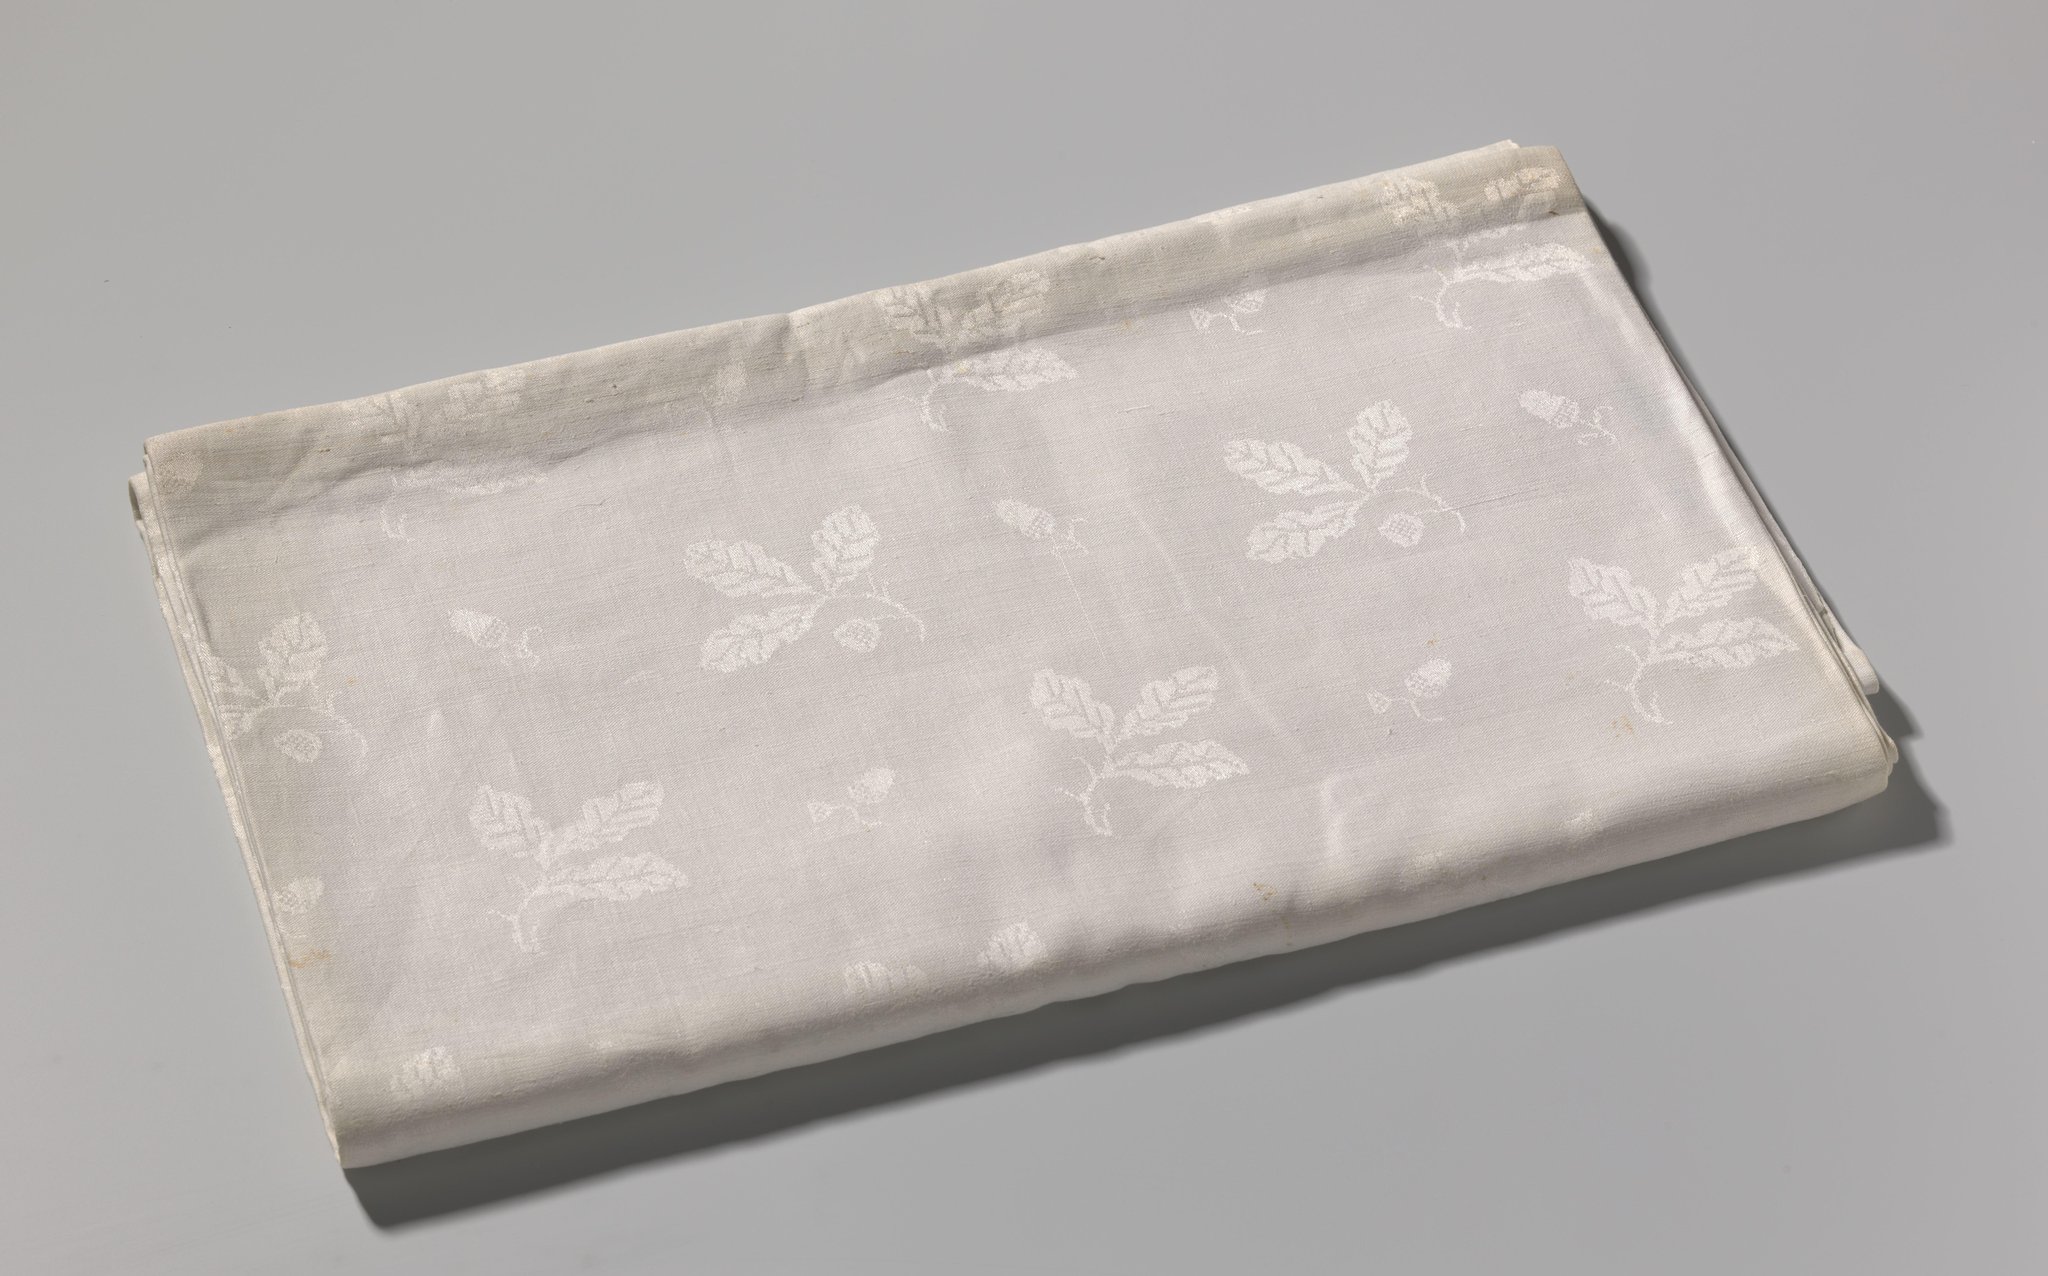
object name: tablecloth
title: Tafellaken van linnendamast met wapens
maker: Anonymous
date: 1803-1825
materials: linen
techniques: damask, weave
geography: low countries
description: Tafellaken van linnendamast met in de hoeken de wapens van d'Achard (?). Middenvlak strooipatroon van eikels en eikenbladeren. Het laken hoort bij twee servetten (BK-1971-244-A en BK-1971-244-B) en een dwaal of loper (BK-1971-246).